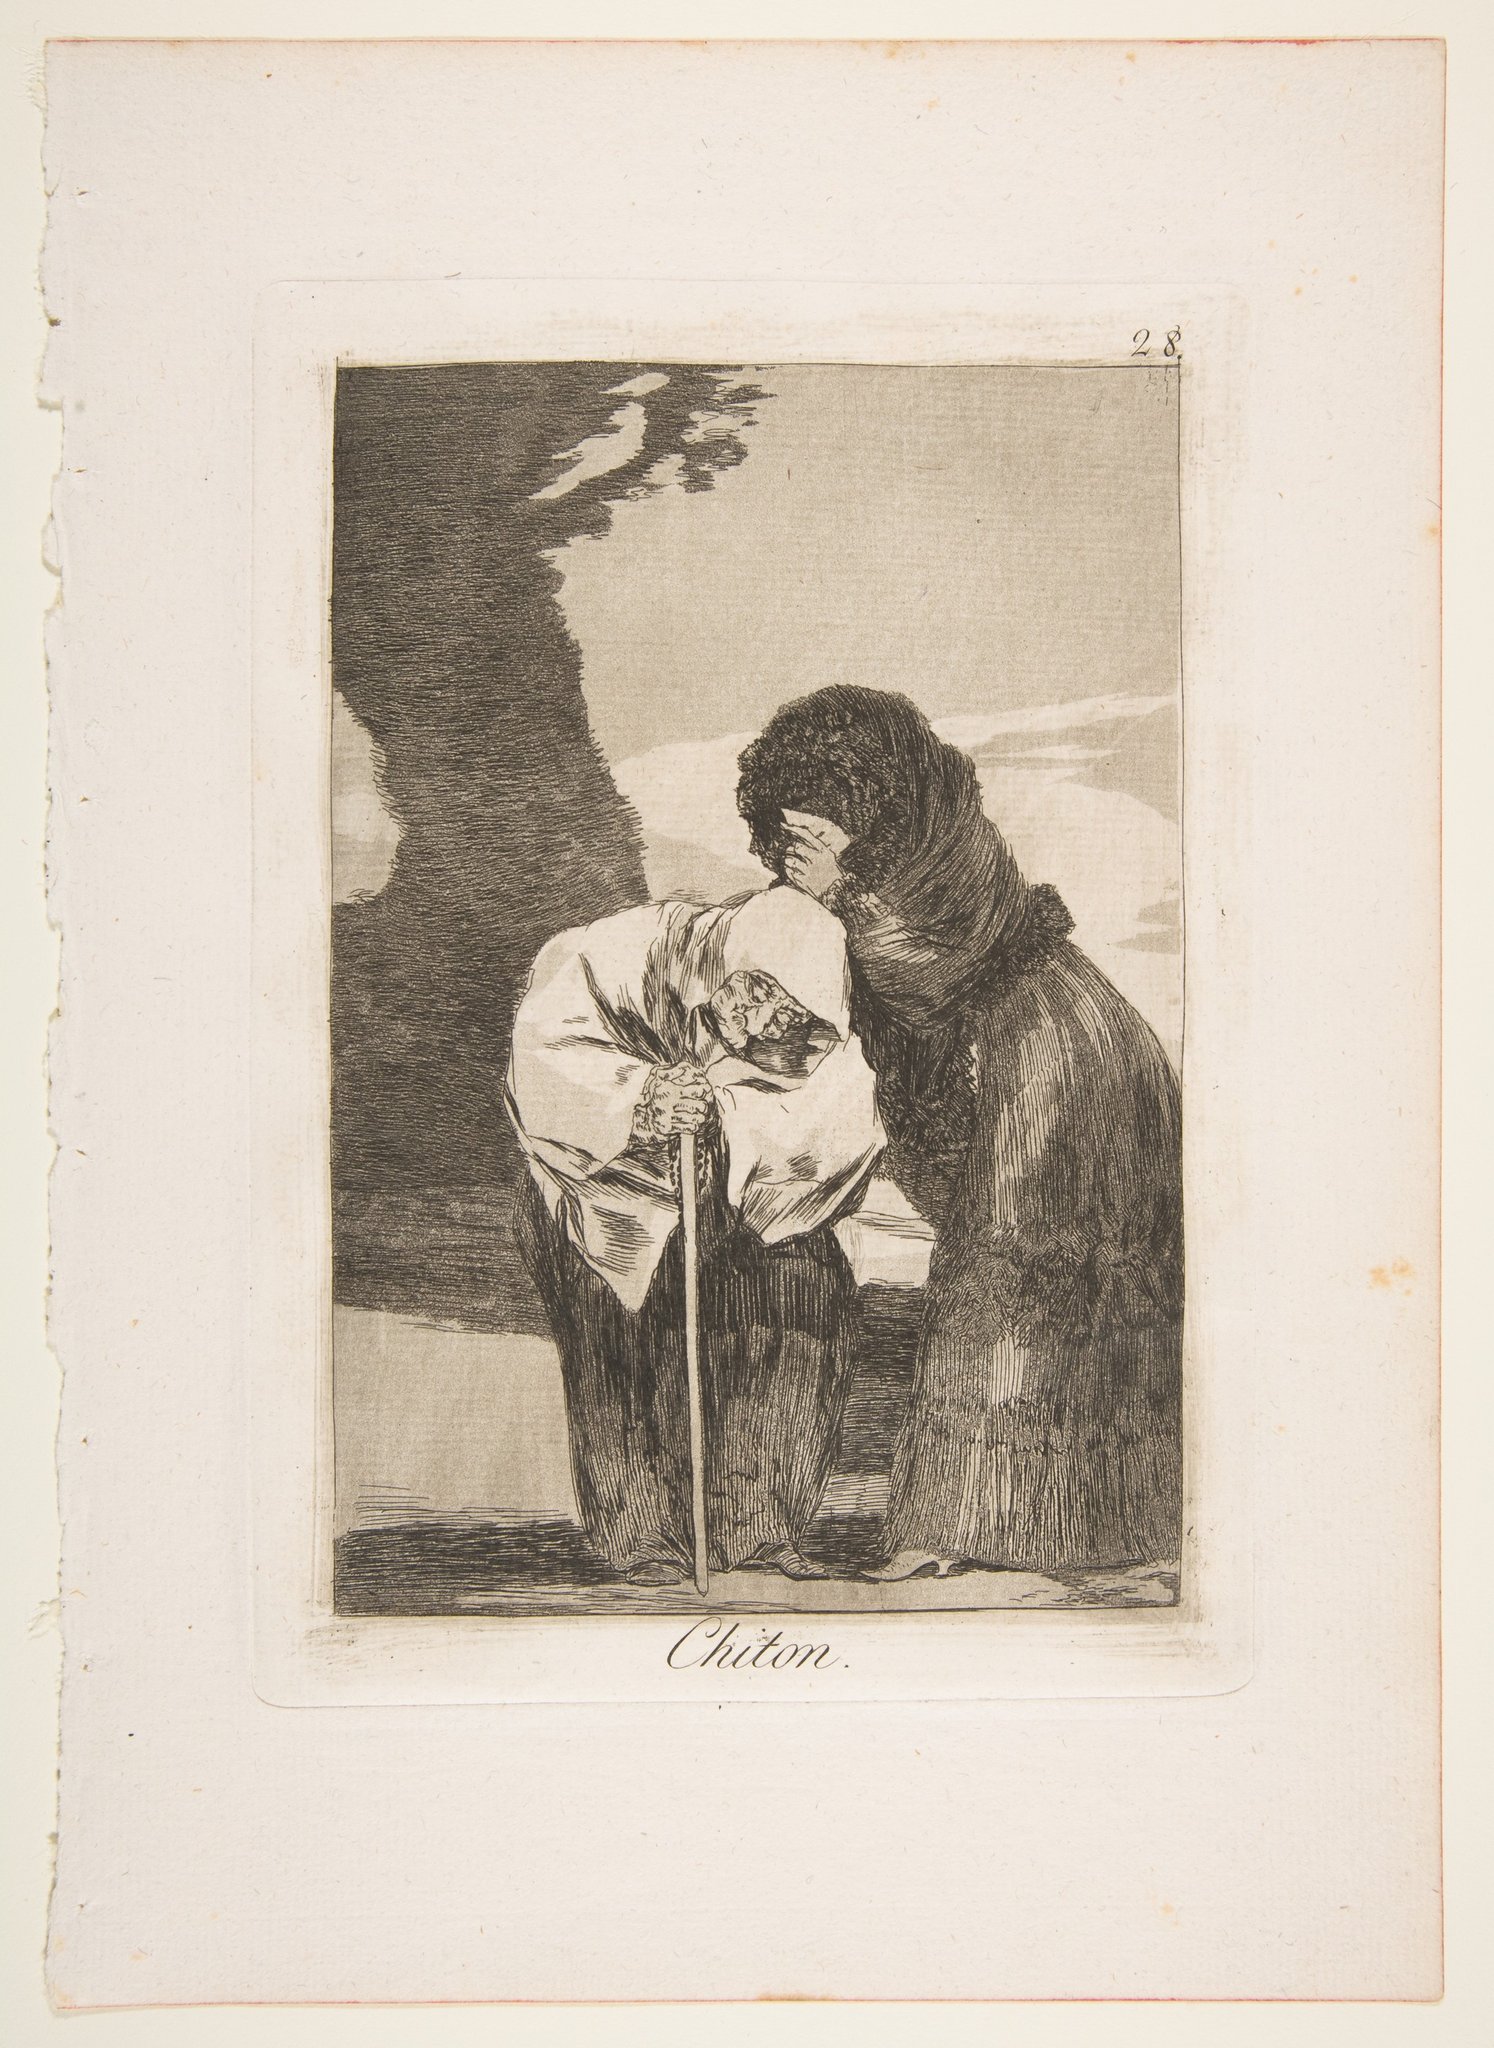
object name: print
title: Plate 28 from "Los Caprichos": Hush (Chiton)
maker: goya (francisco de goya y lucientes)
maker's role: artist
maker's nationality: spanish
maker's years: 1746-1828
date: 1799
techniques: aquatint, engraving, etching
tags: women